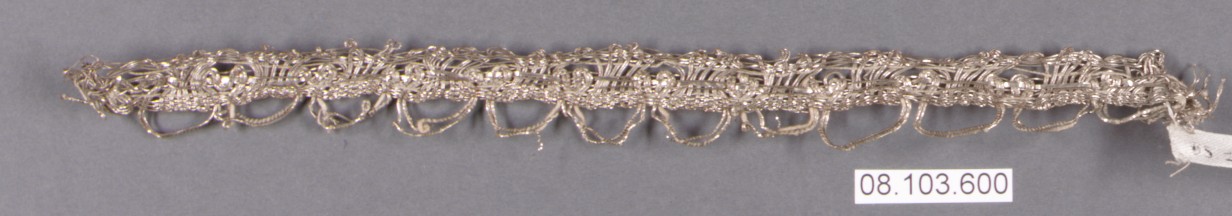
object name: galloon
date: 1701-1800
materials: metal thread